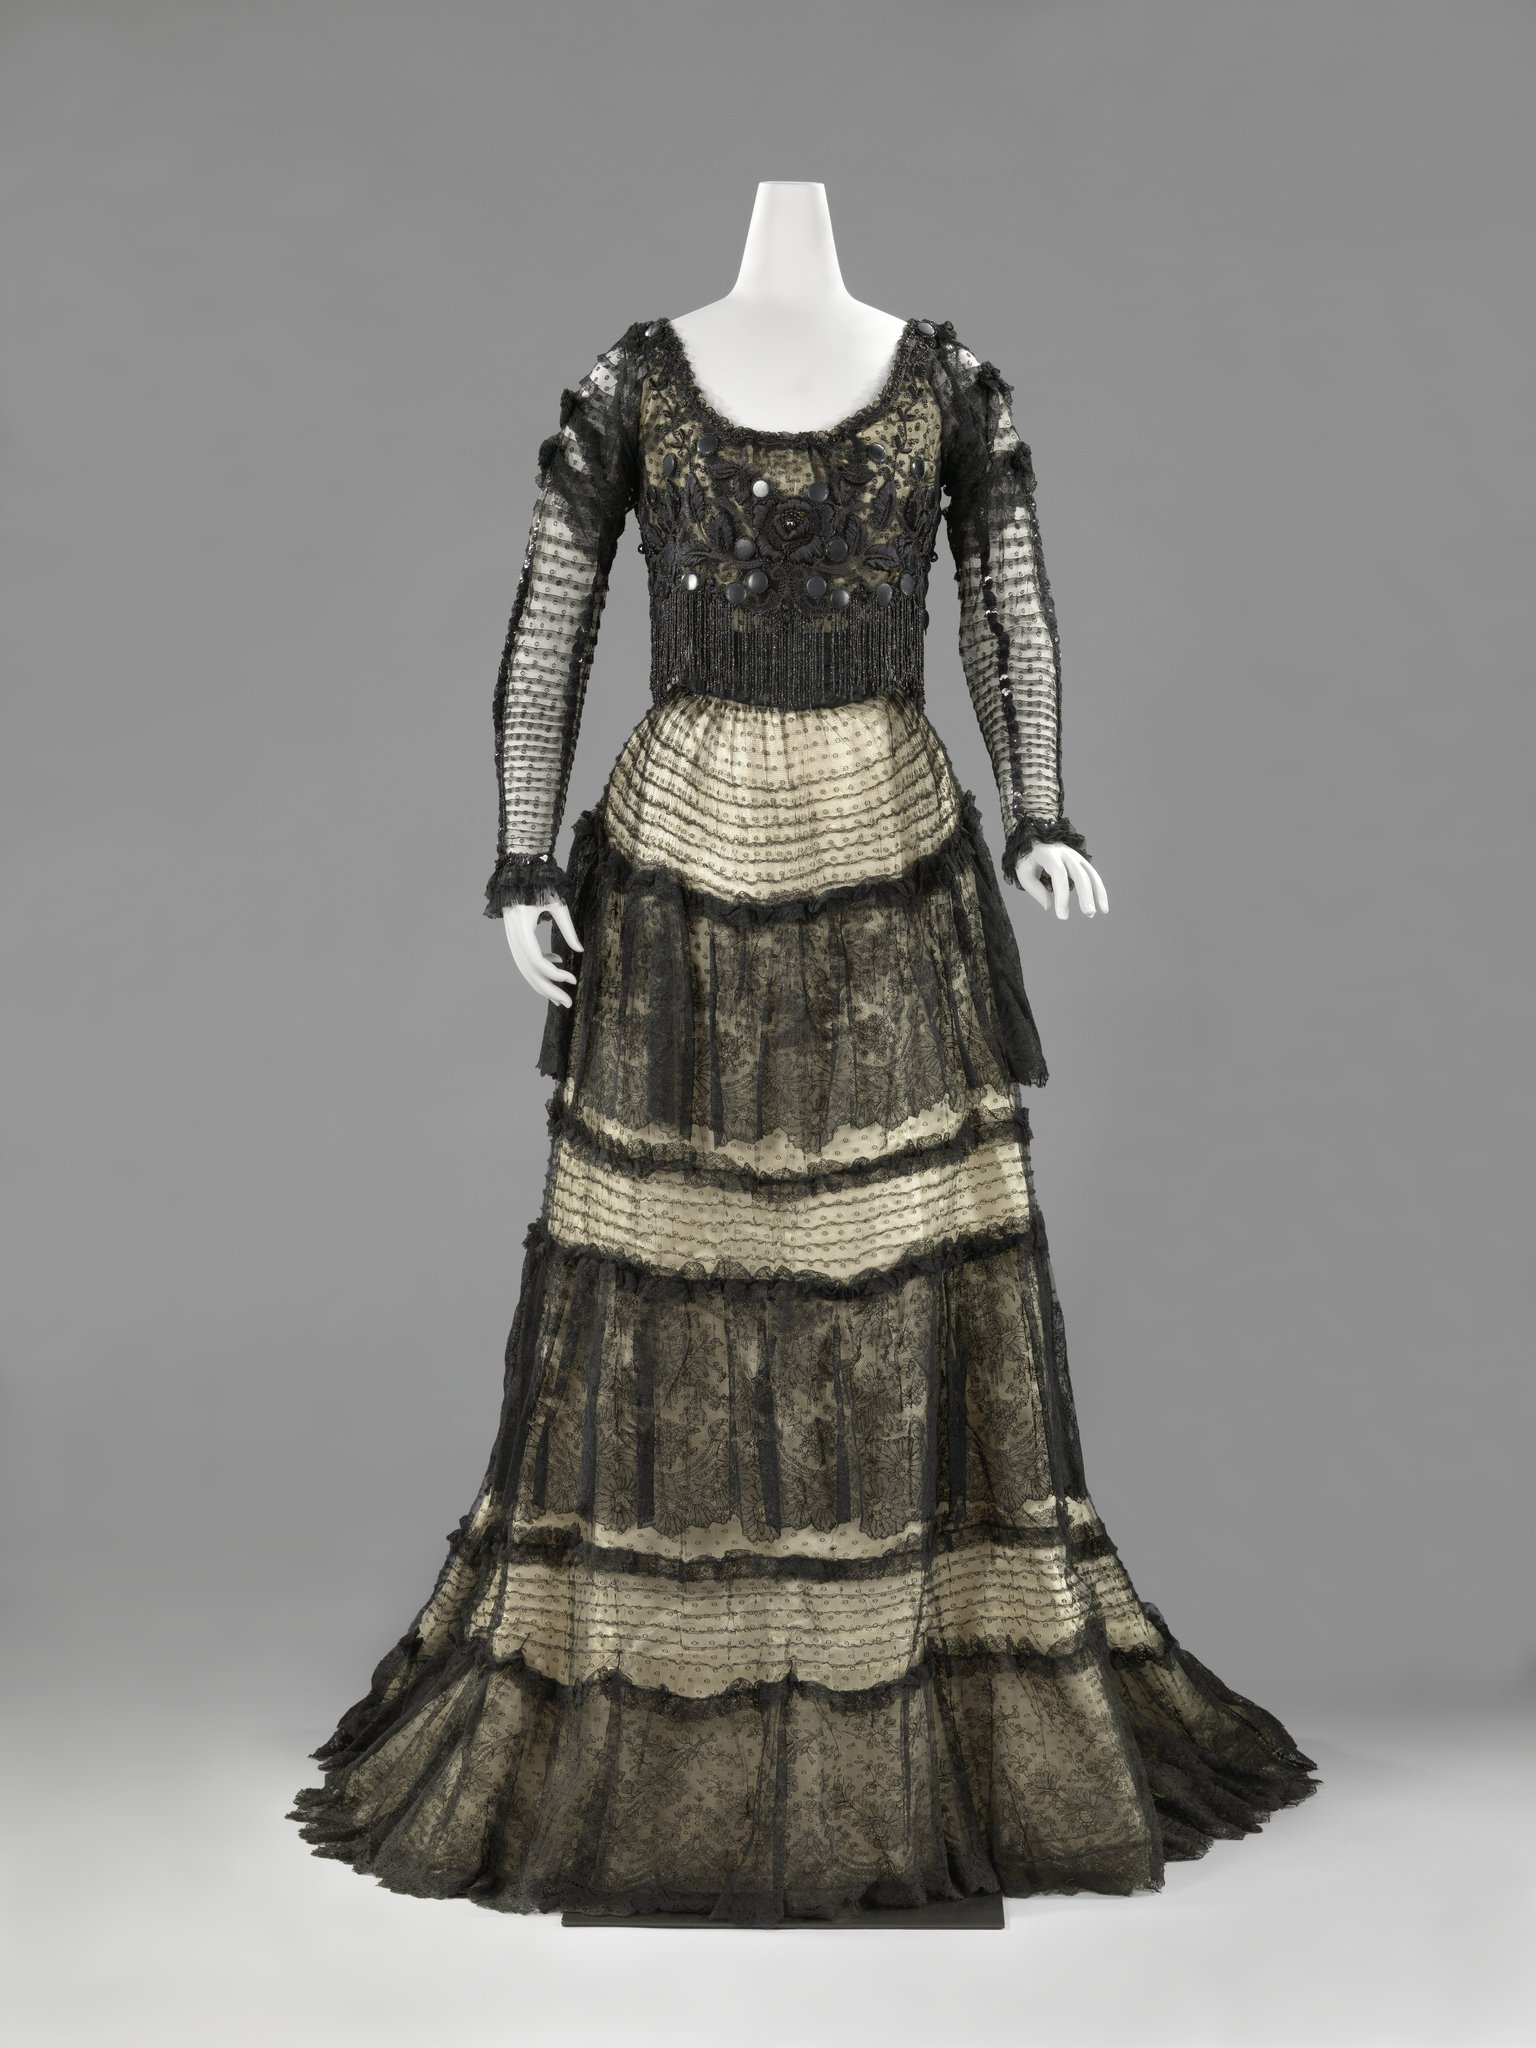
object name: womenswear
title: Lijf met lange mouwen van crème satijn onder zwart kant, versierd met zwarte grote geborduurde bloem- en bladmotieven, kralen, pailletten en knopen; zwart satijnen ceintuur.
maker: lucien andrain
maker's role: modeontwerper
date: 1903-1906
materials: textile, silk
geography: paris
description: Lijf horend bij een japon van zwarte kant op een crême satijnen onderkleed. Gedecolleteerd en met lange mouwen. Gegarneerd met zwarte tule, knopen en kralen. Op de trekband het adres: Lucien Andrain, 73 Rue de Rivoli, Paris.